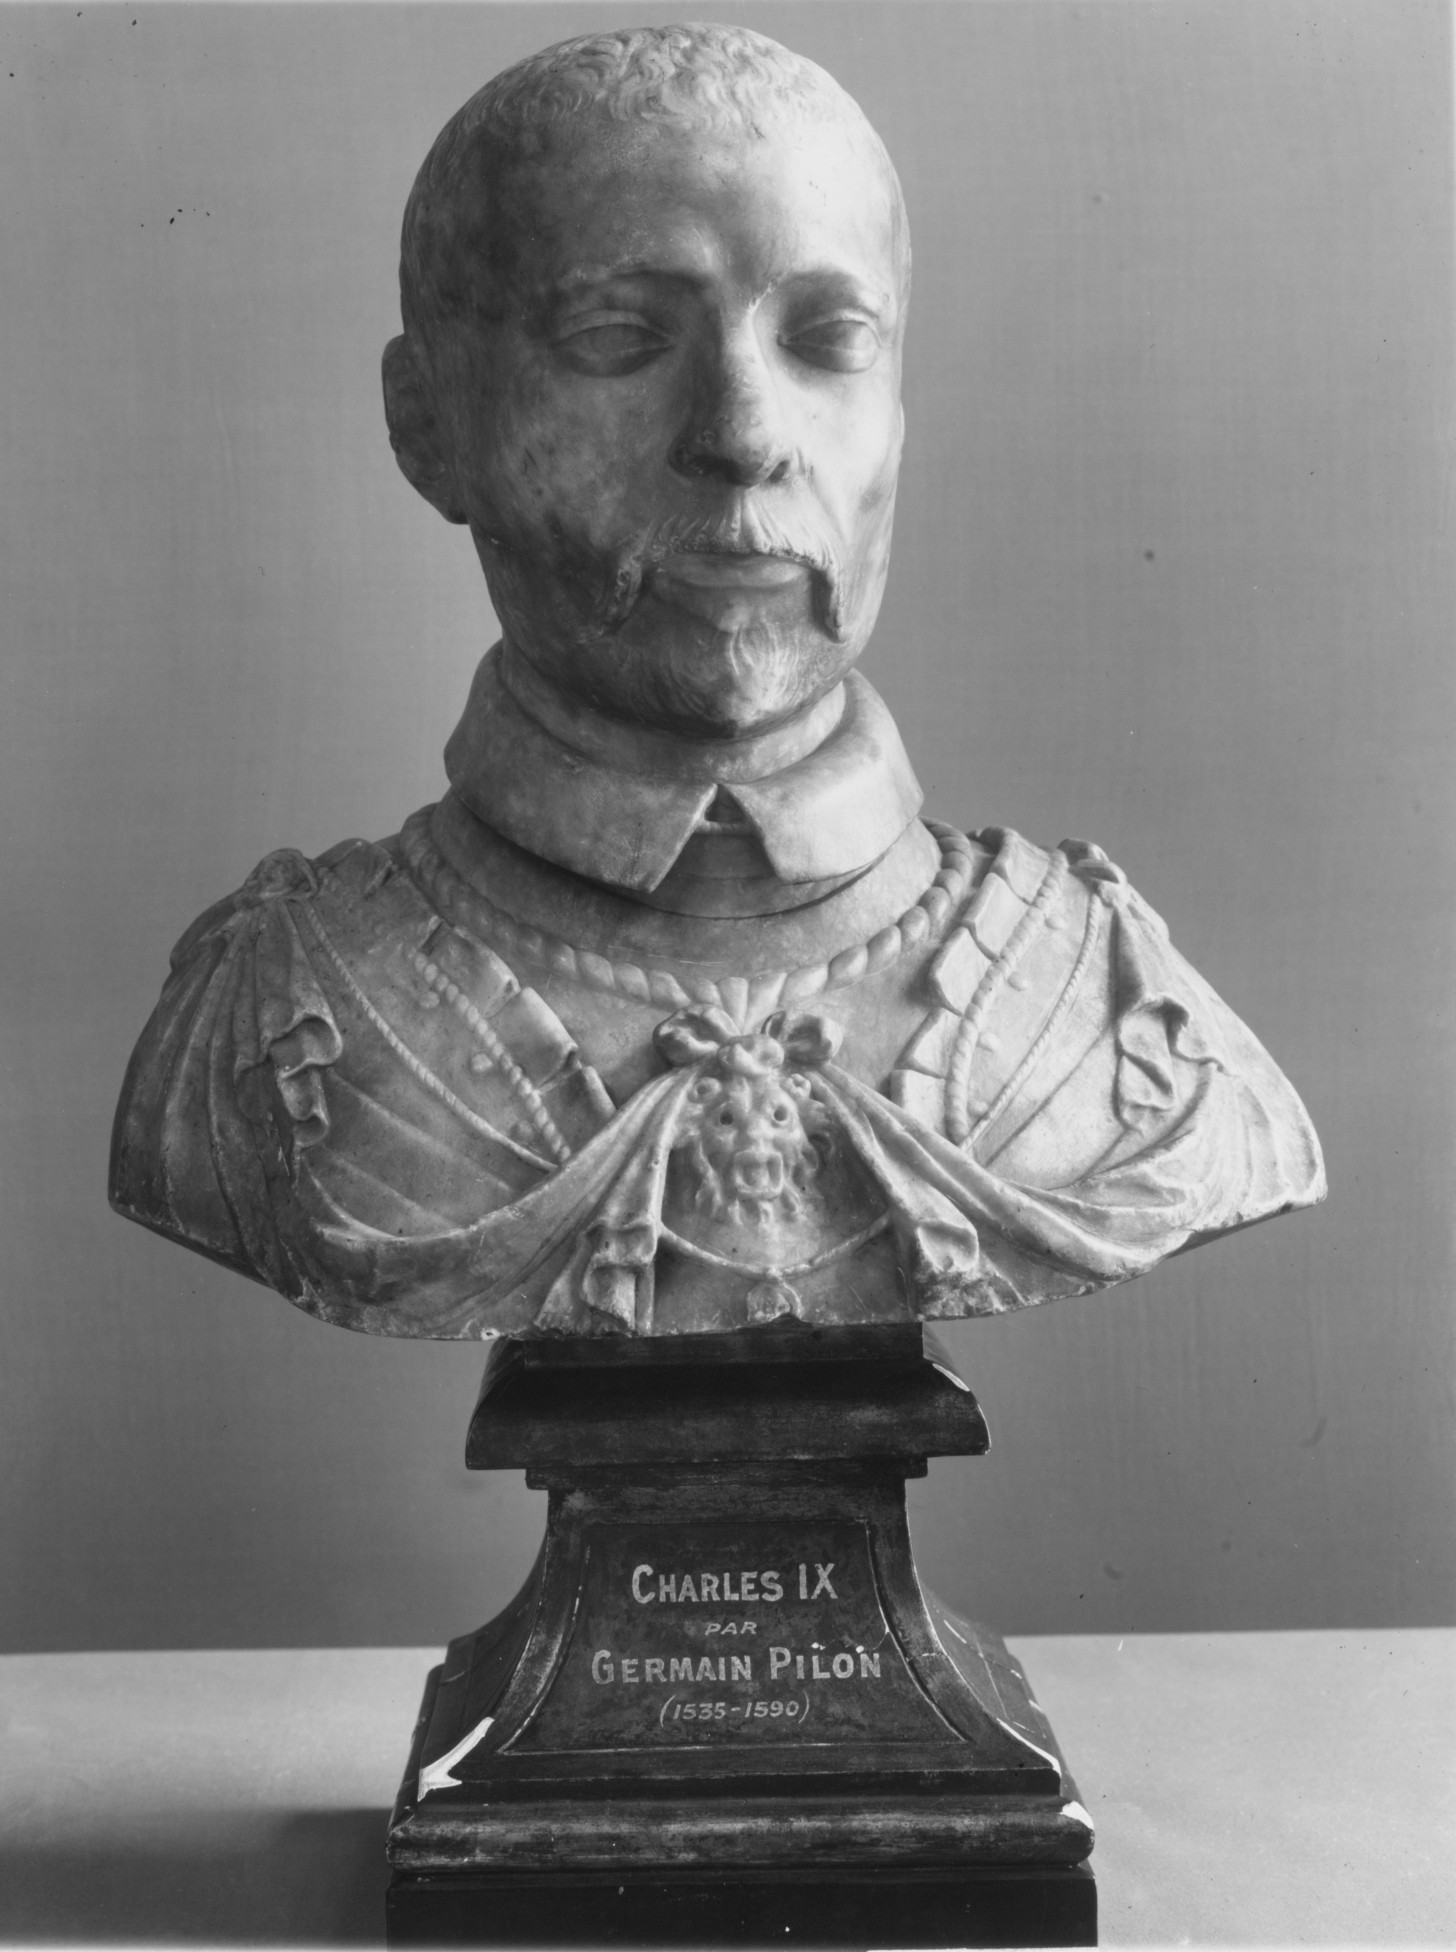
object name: bust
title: Henri III (1551–1589)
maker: germain pilon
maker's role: artist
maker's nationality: french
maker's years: 1525-1590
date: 1801-1900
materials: marble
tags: men,portraits